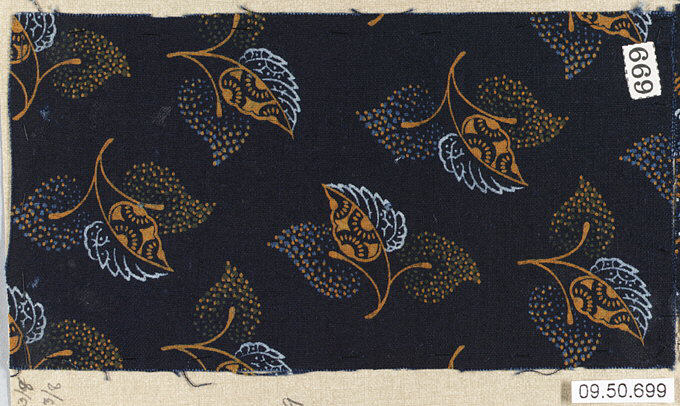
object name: piece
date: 1801-1900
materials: cotton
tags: leaves